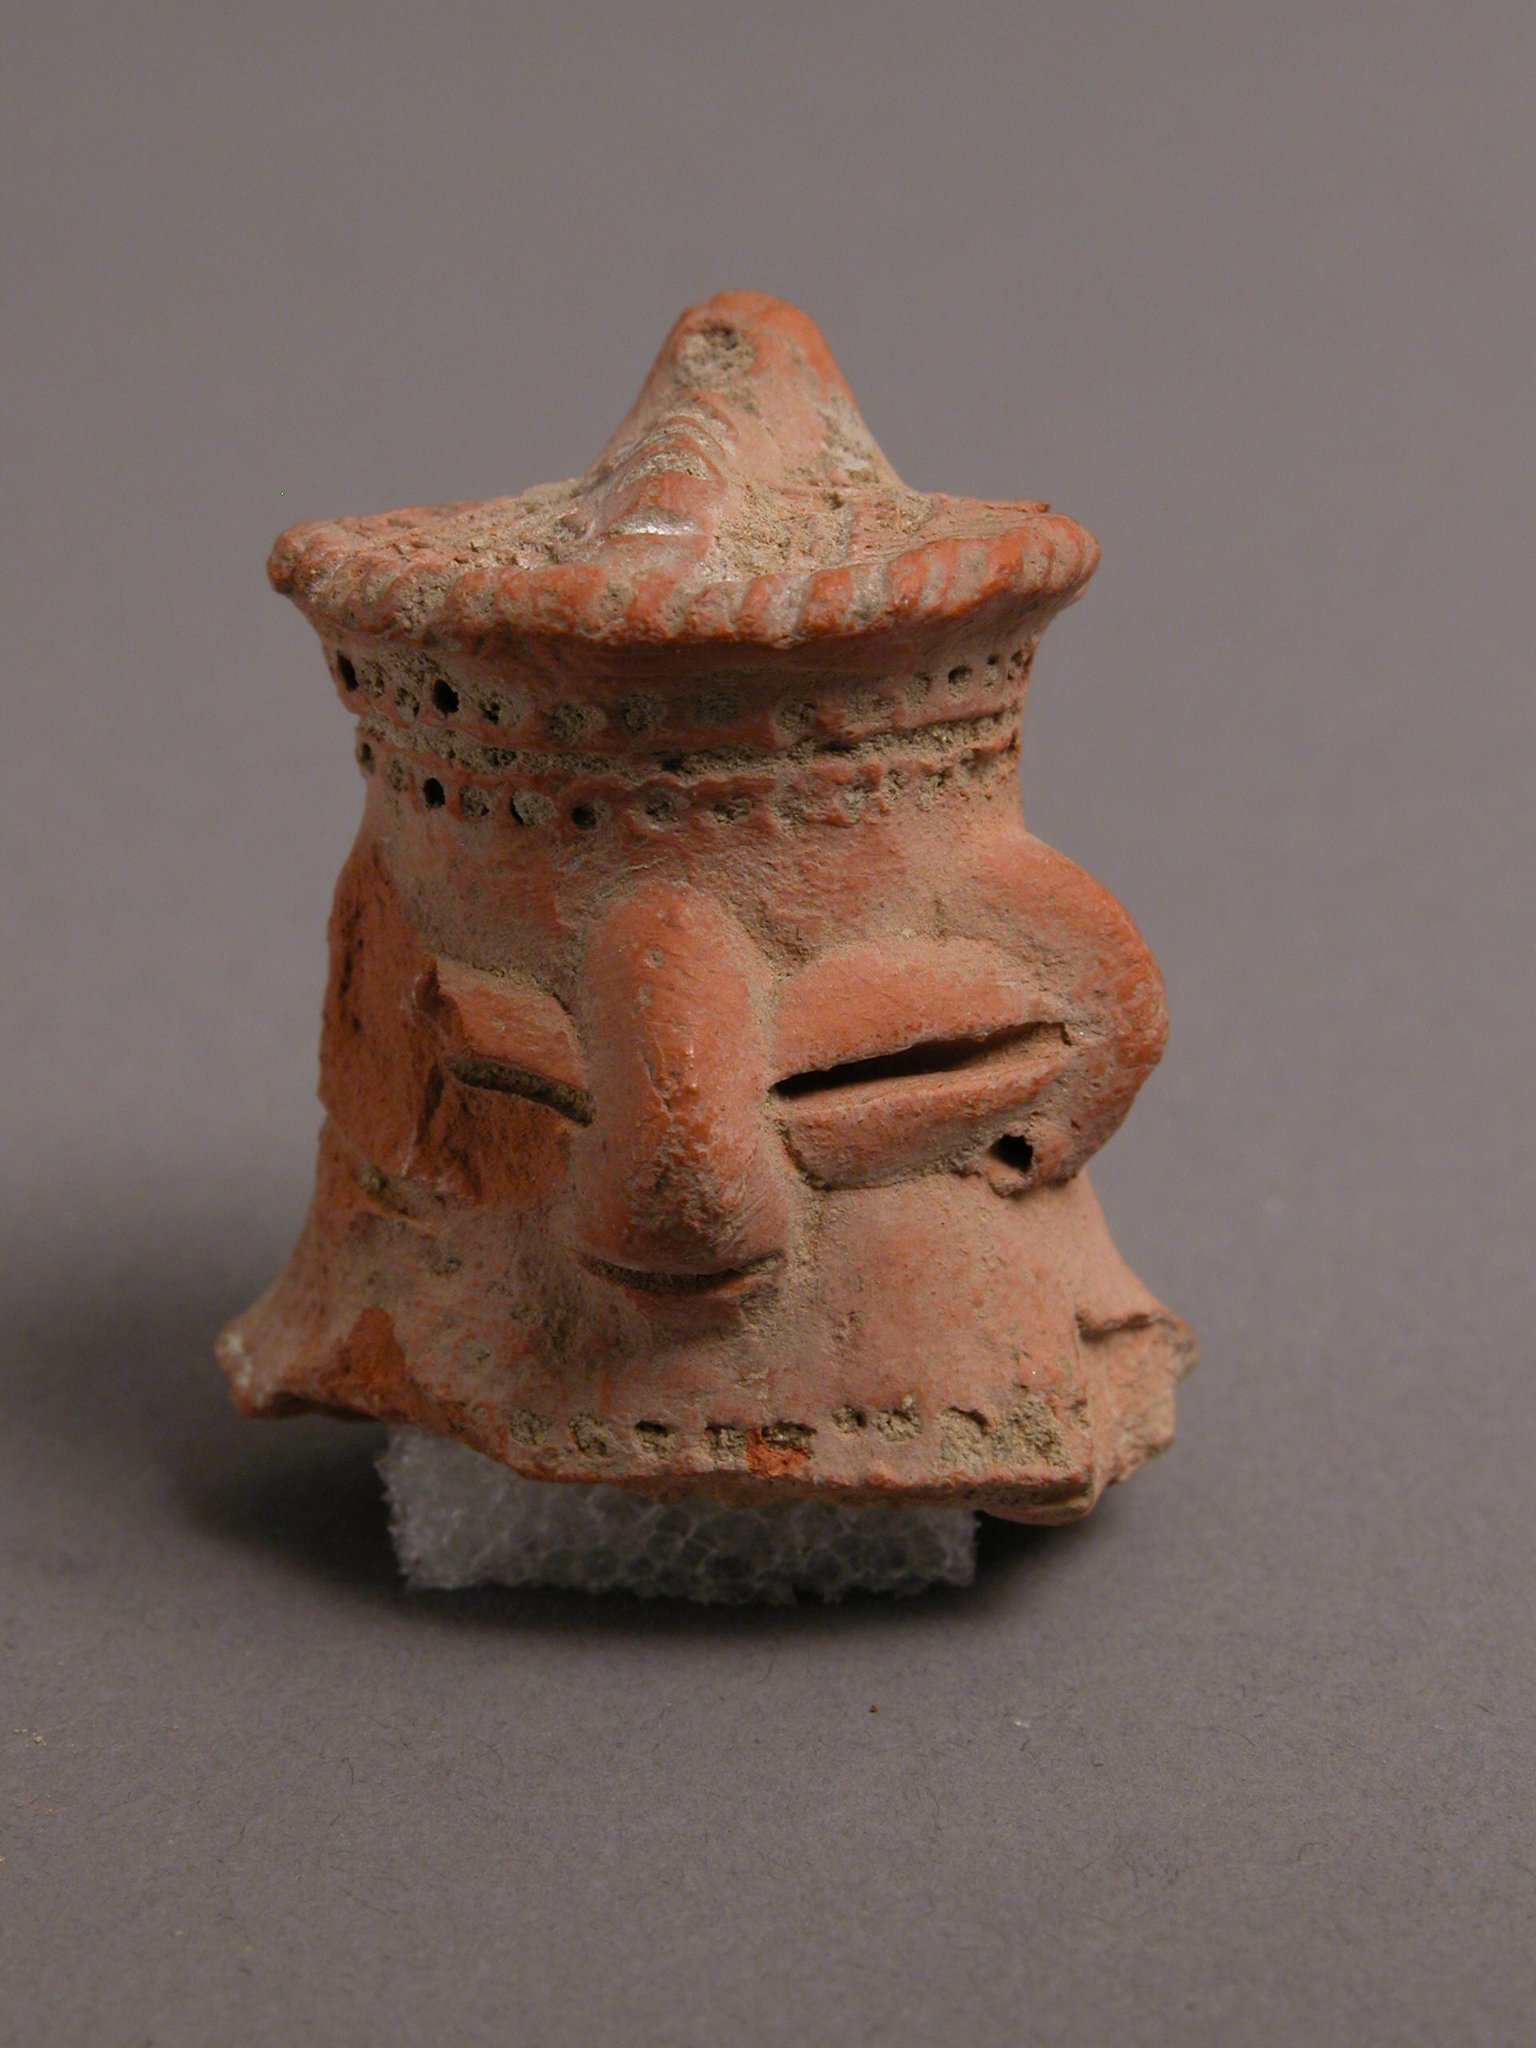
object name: statuette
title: Head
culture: coptic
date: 301-700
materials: earthenware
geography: egypt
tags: heads